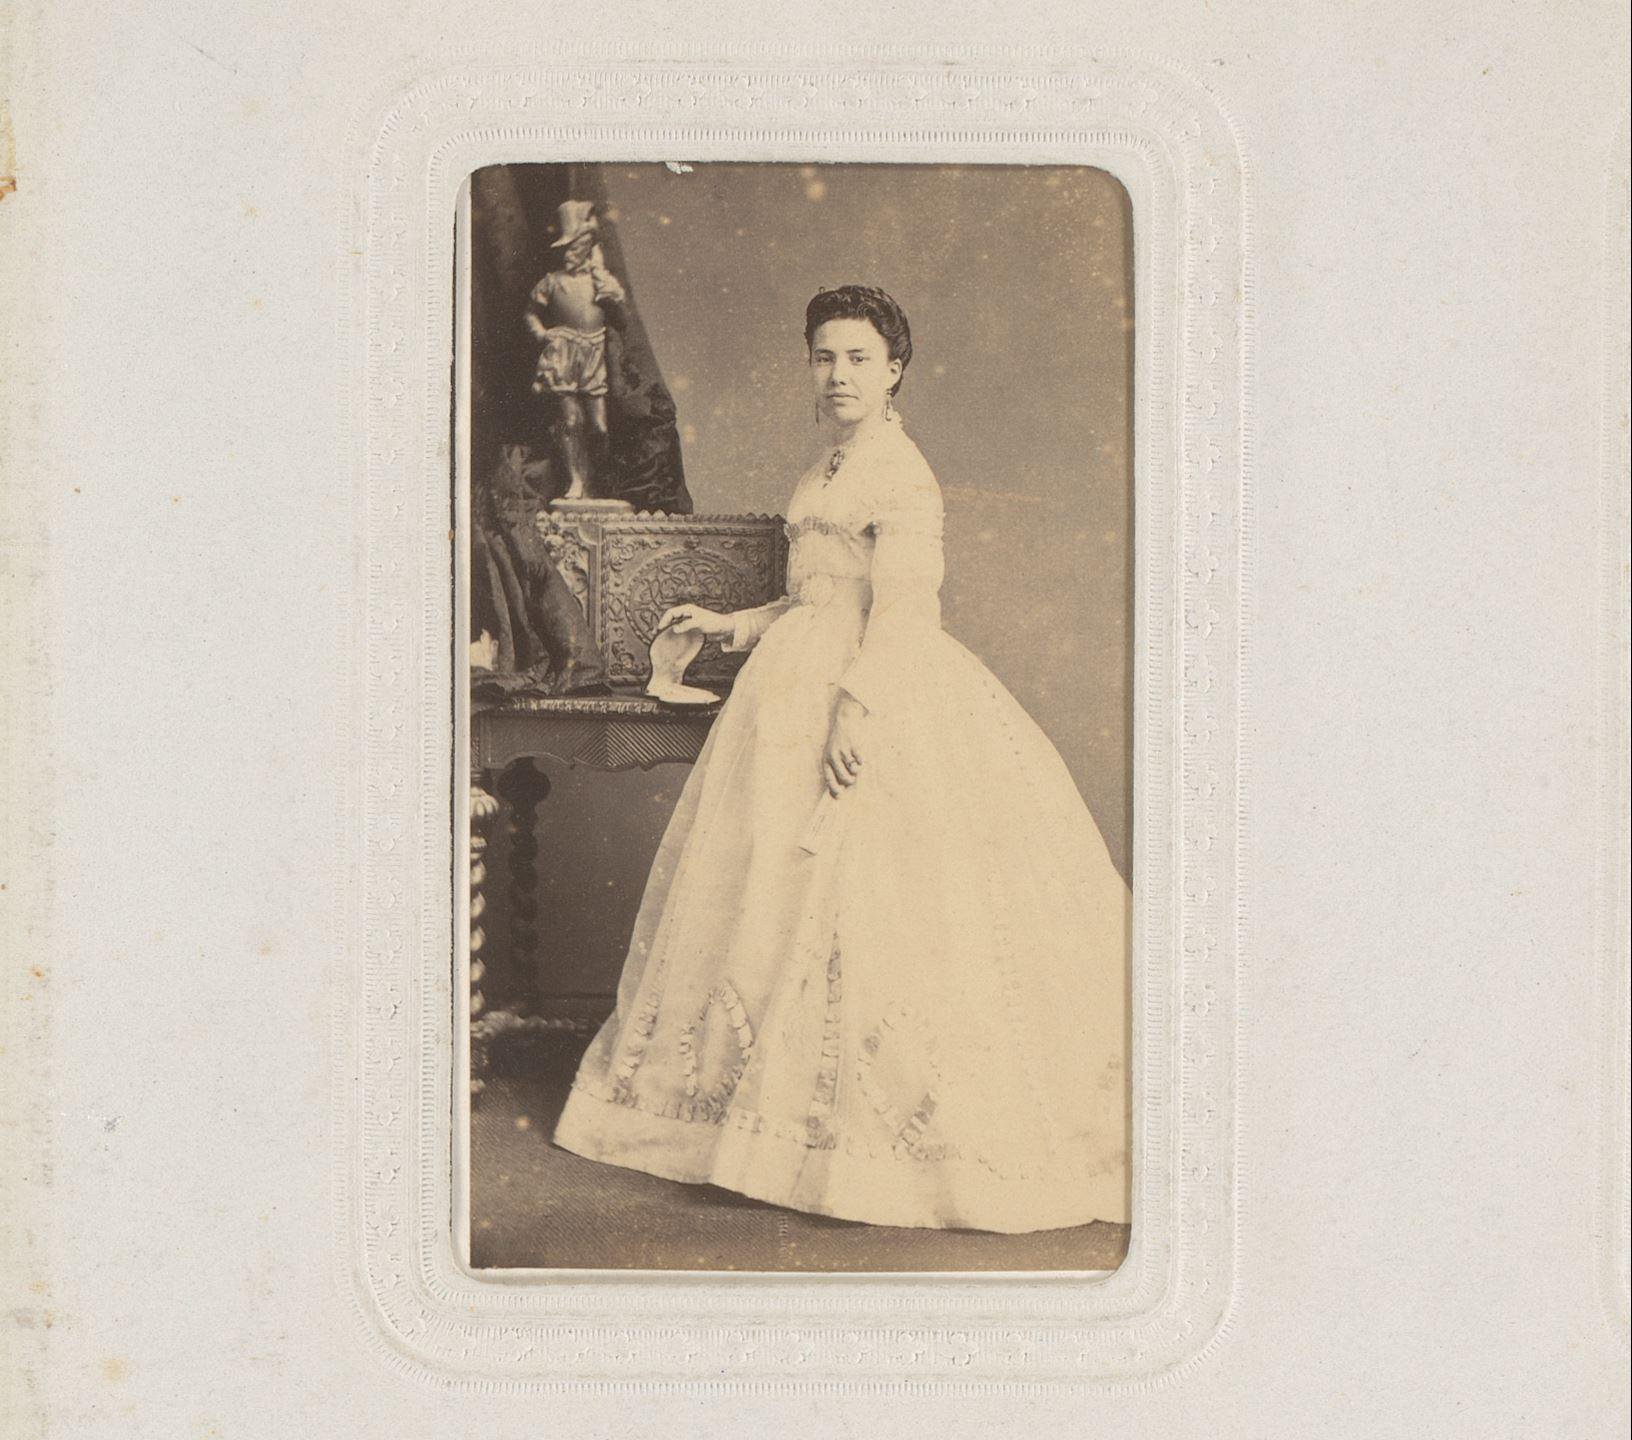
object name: photograph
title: Portret van een jonge vrouw met waaier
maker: samuel a. cohner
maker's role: fotograaf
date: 1860-1890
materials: cardboard, photographic support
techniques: albumen print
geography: havana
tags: historical persons - bb - woman, fan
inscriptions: inscription: ‘S.A. Cohner/ O'Reilly No 62/ Entre Habana y Compostela/ Habana’